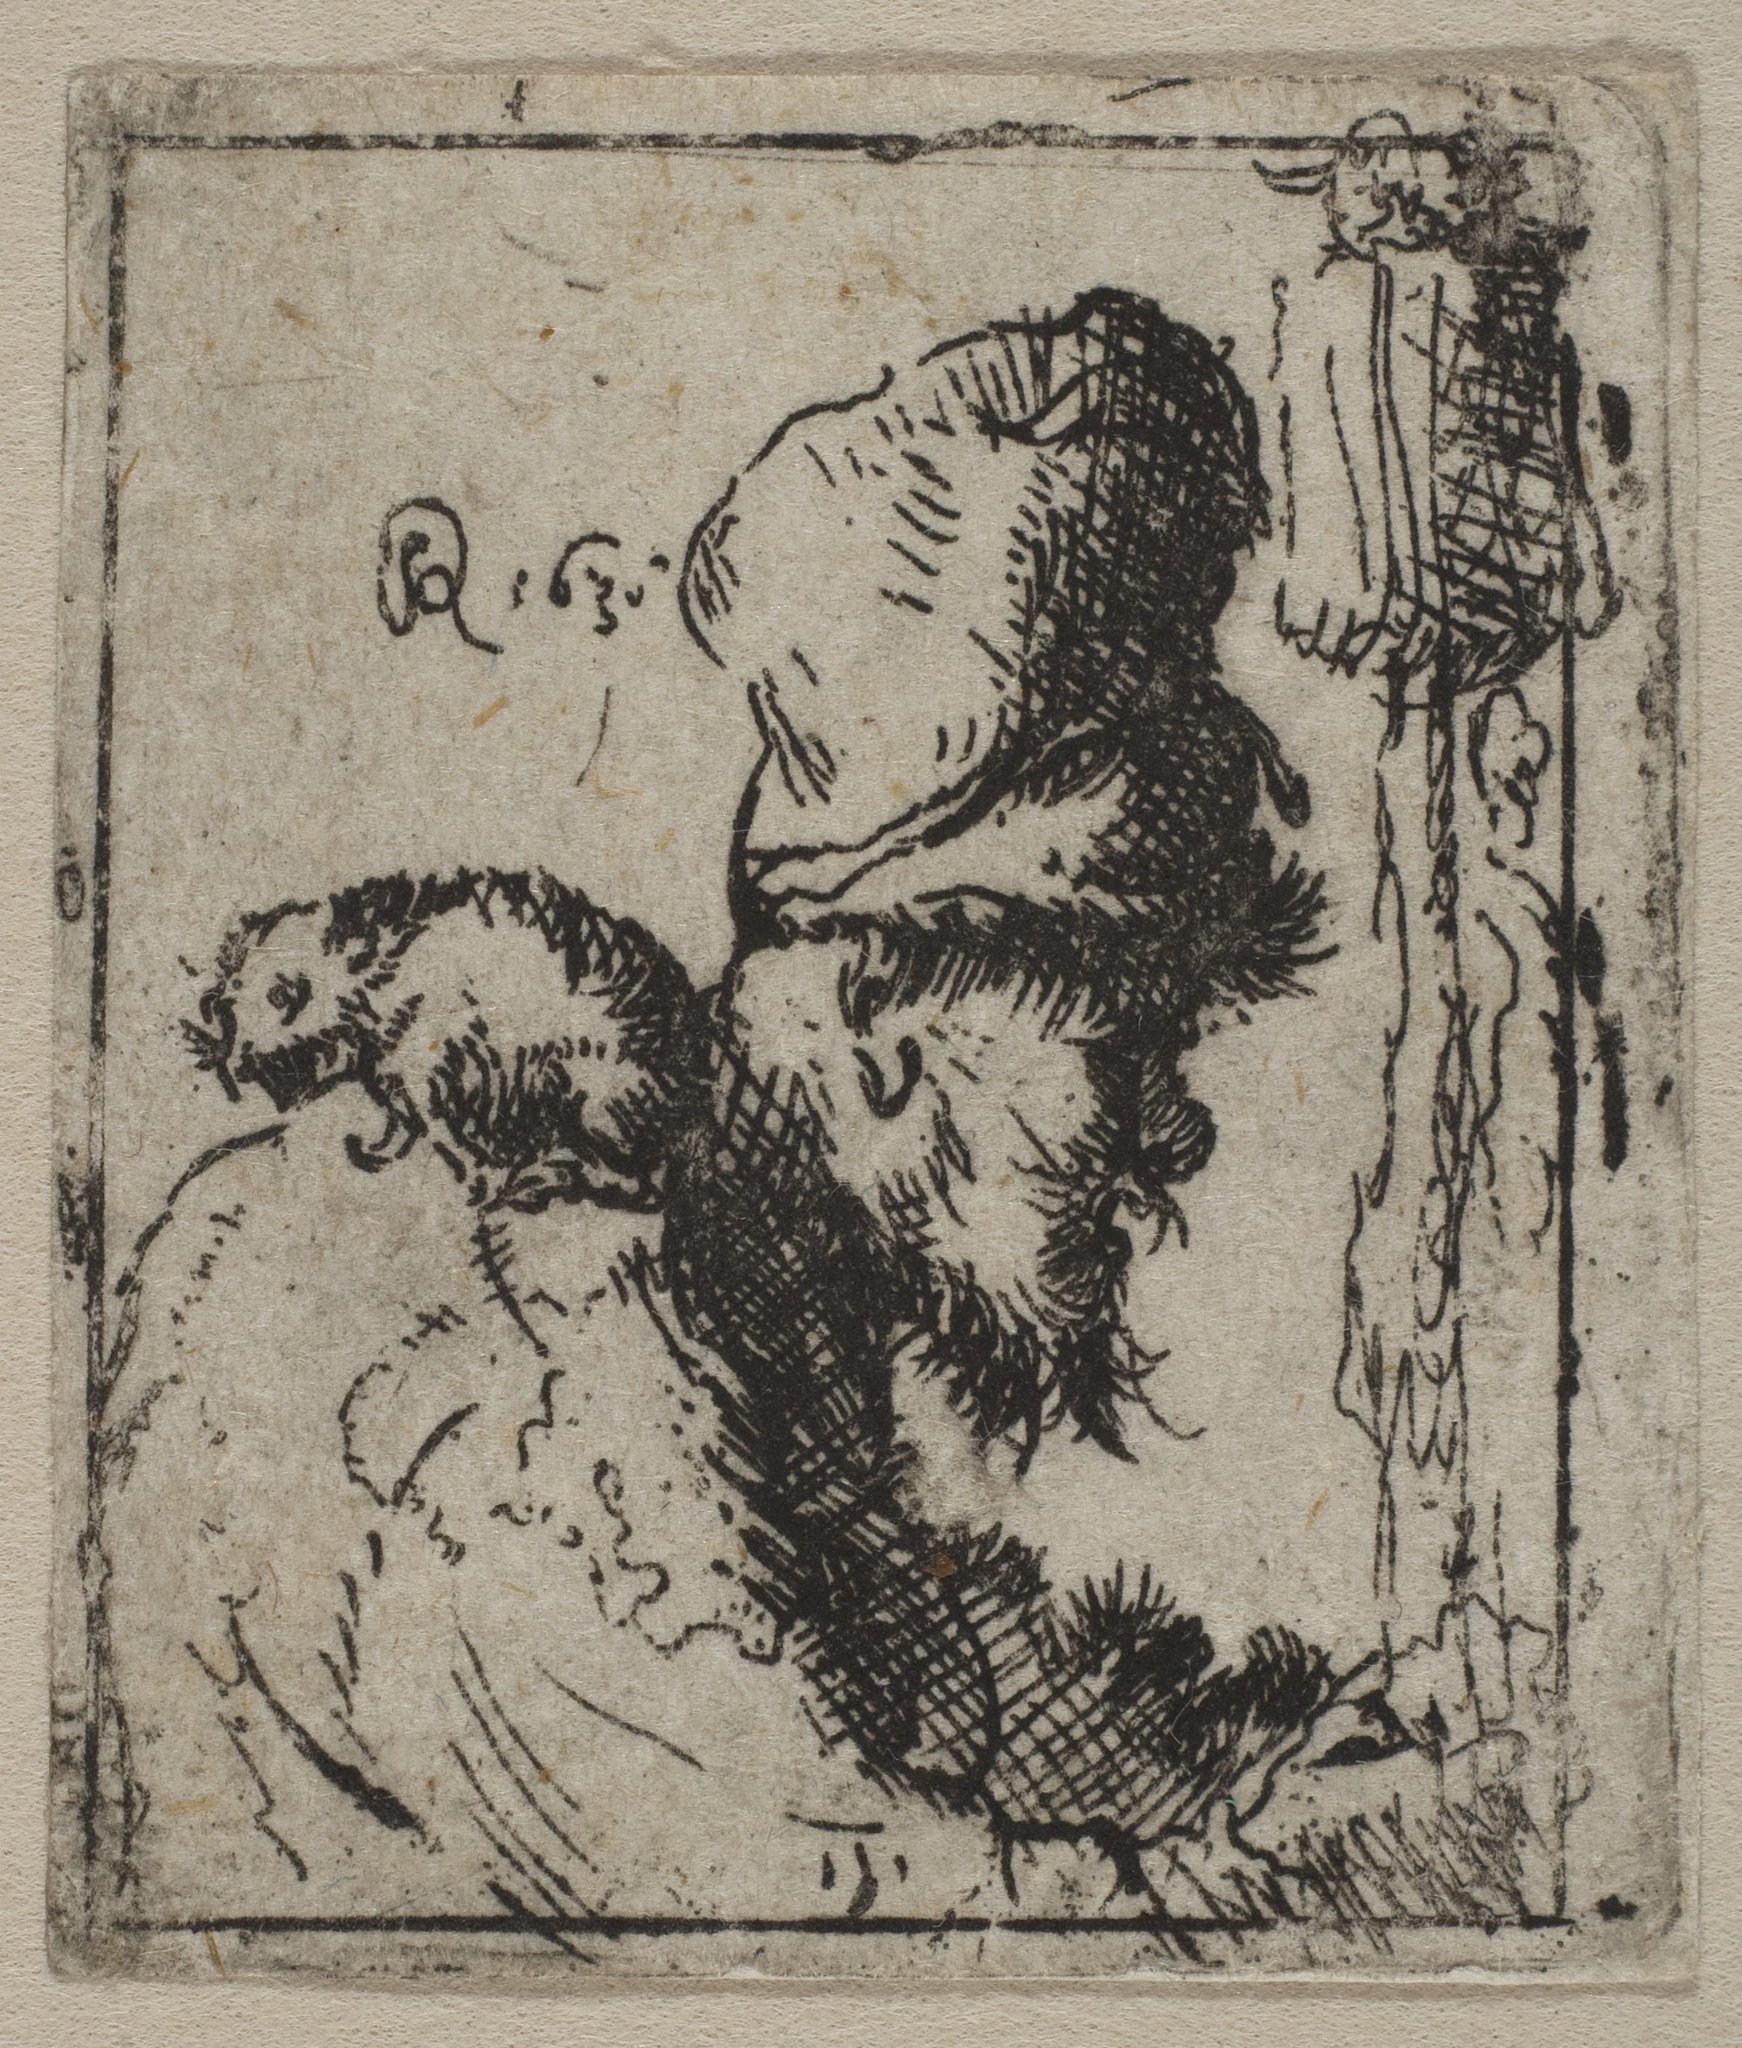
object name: print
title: Head of a Rat Catcher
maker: rembrandt van rijn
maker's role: artist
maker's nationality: dutch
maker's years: 1606-1669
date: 1601-1700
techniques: etching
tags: men,rats